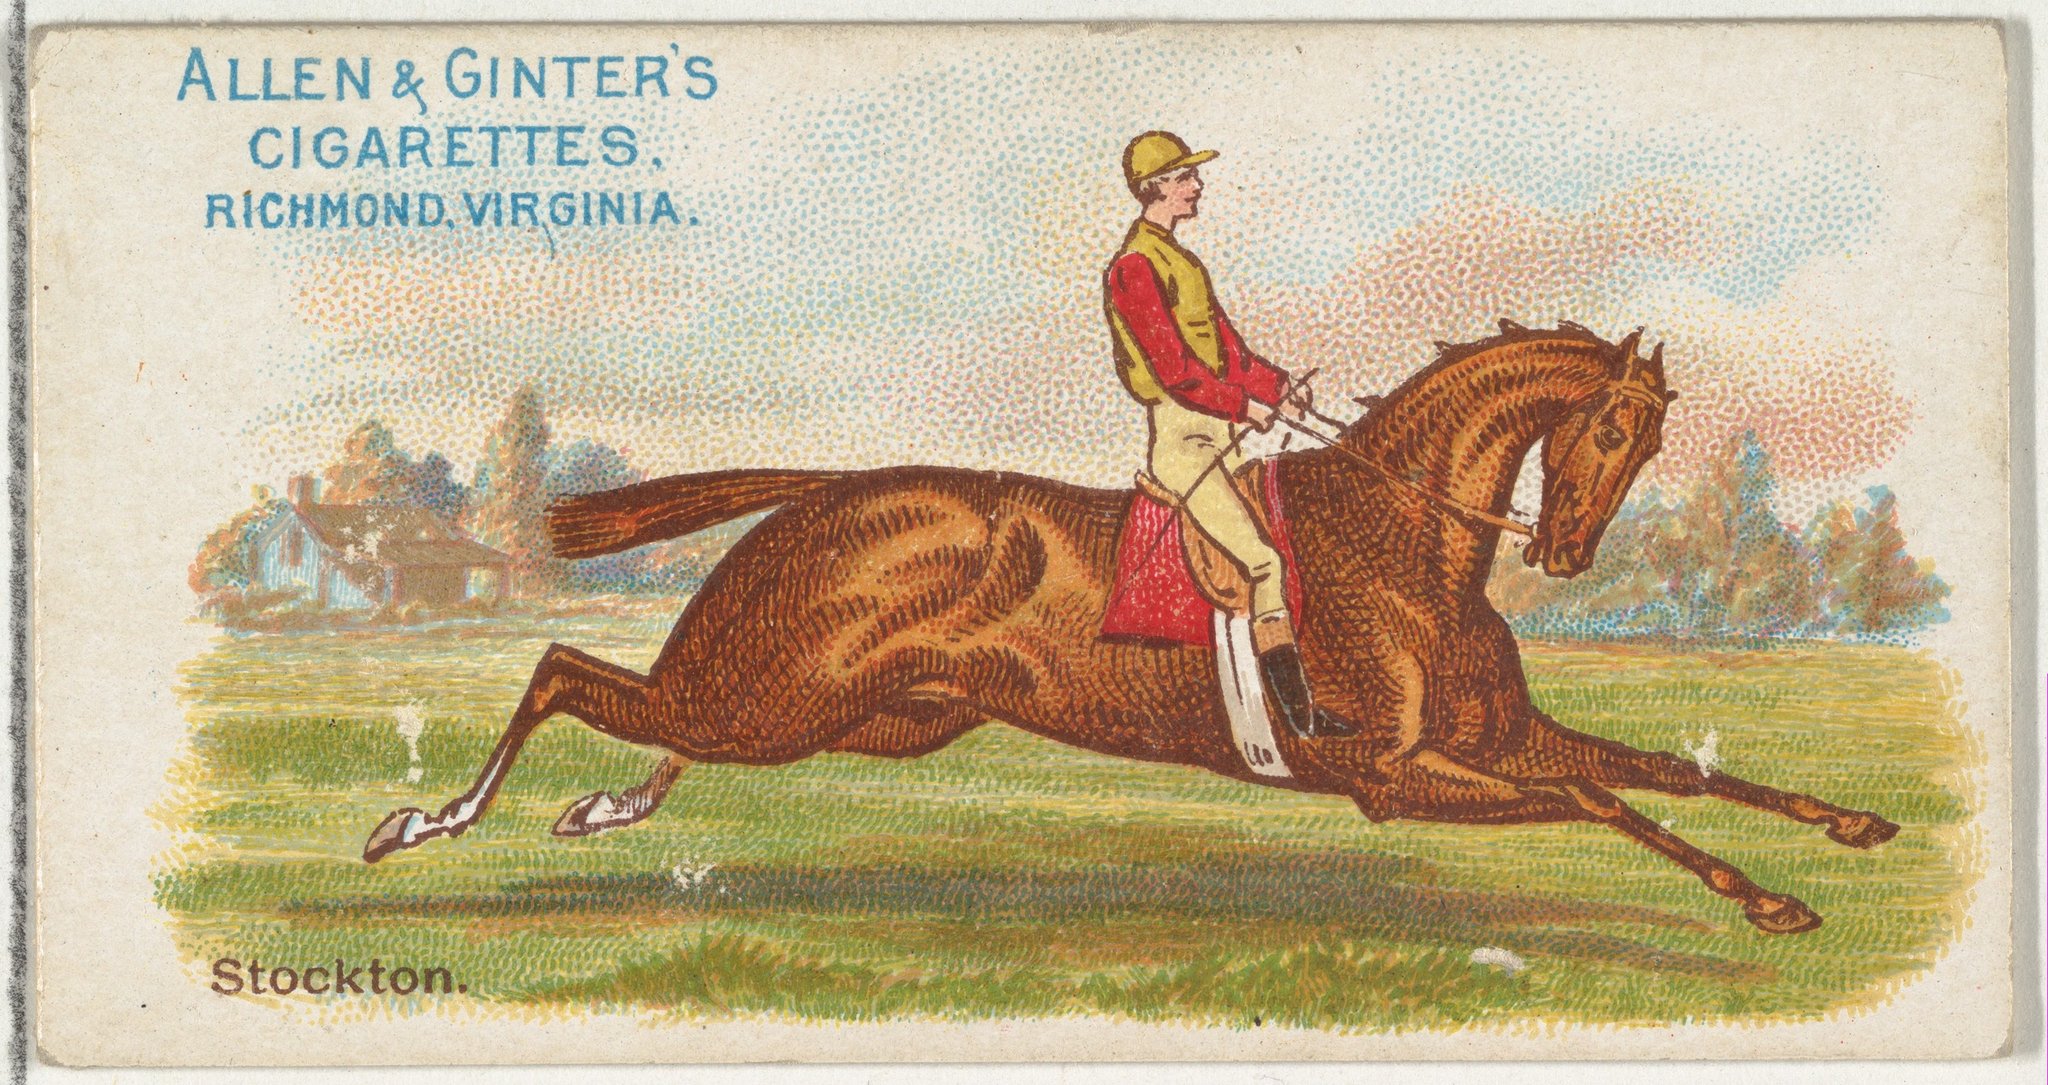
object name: print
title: Stockton, from The World's Racers series (N32) for Allen & Ginter Cigarettes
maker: allen & ginter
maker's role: publisher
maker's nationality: american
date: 1888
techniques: color lithograph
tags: men,horses,jockeys